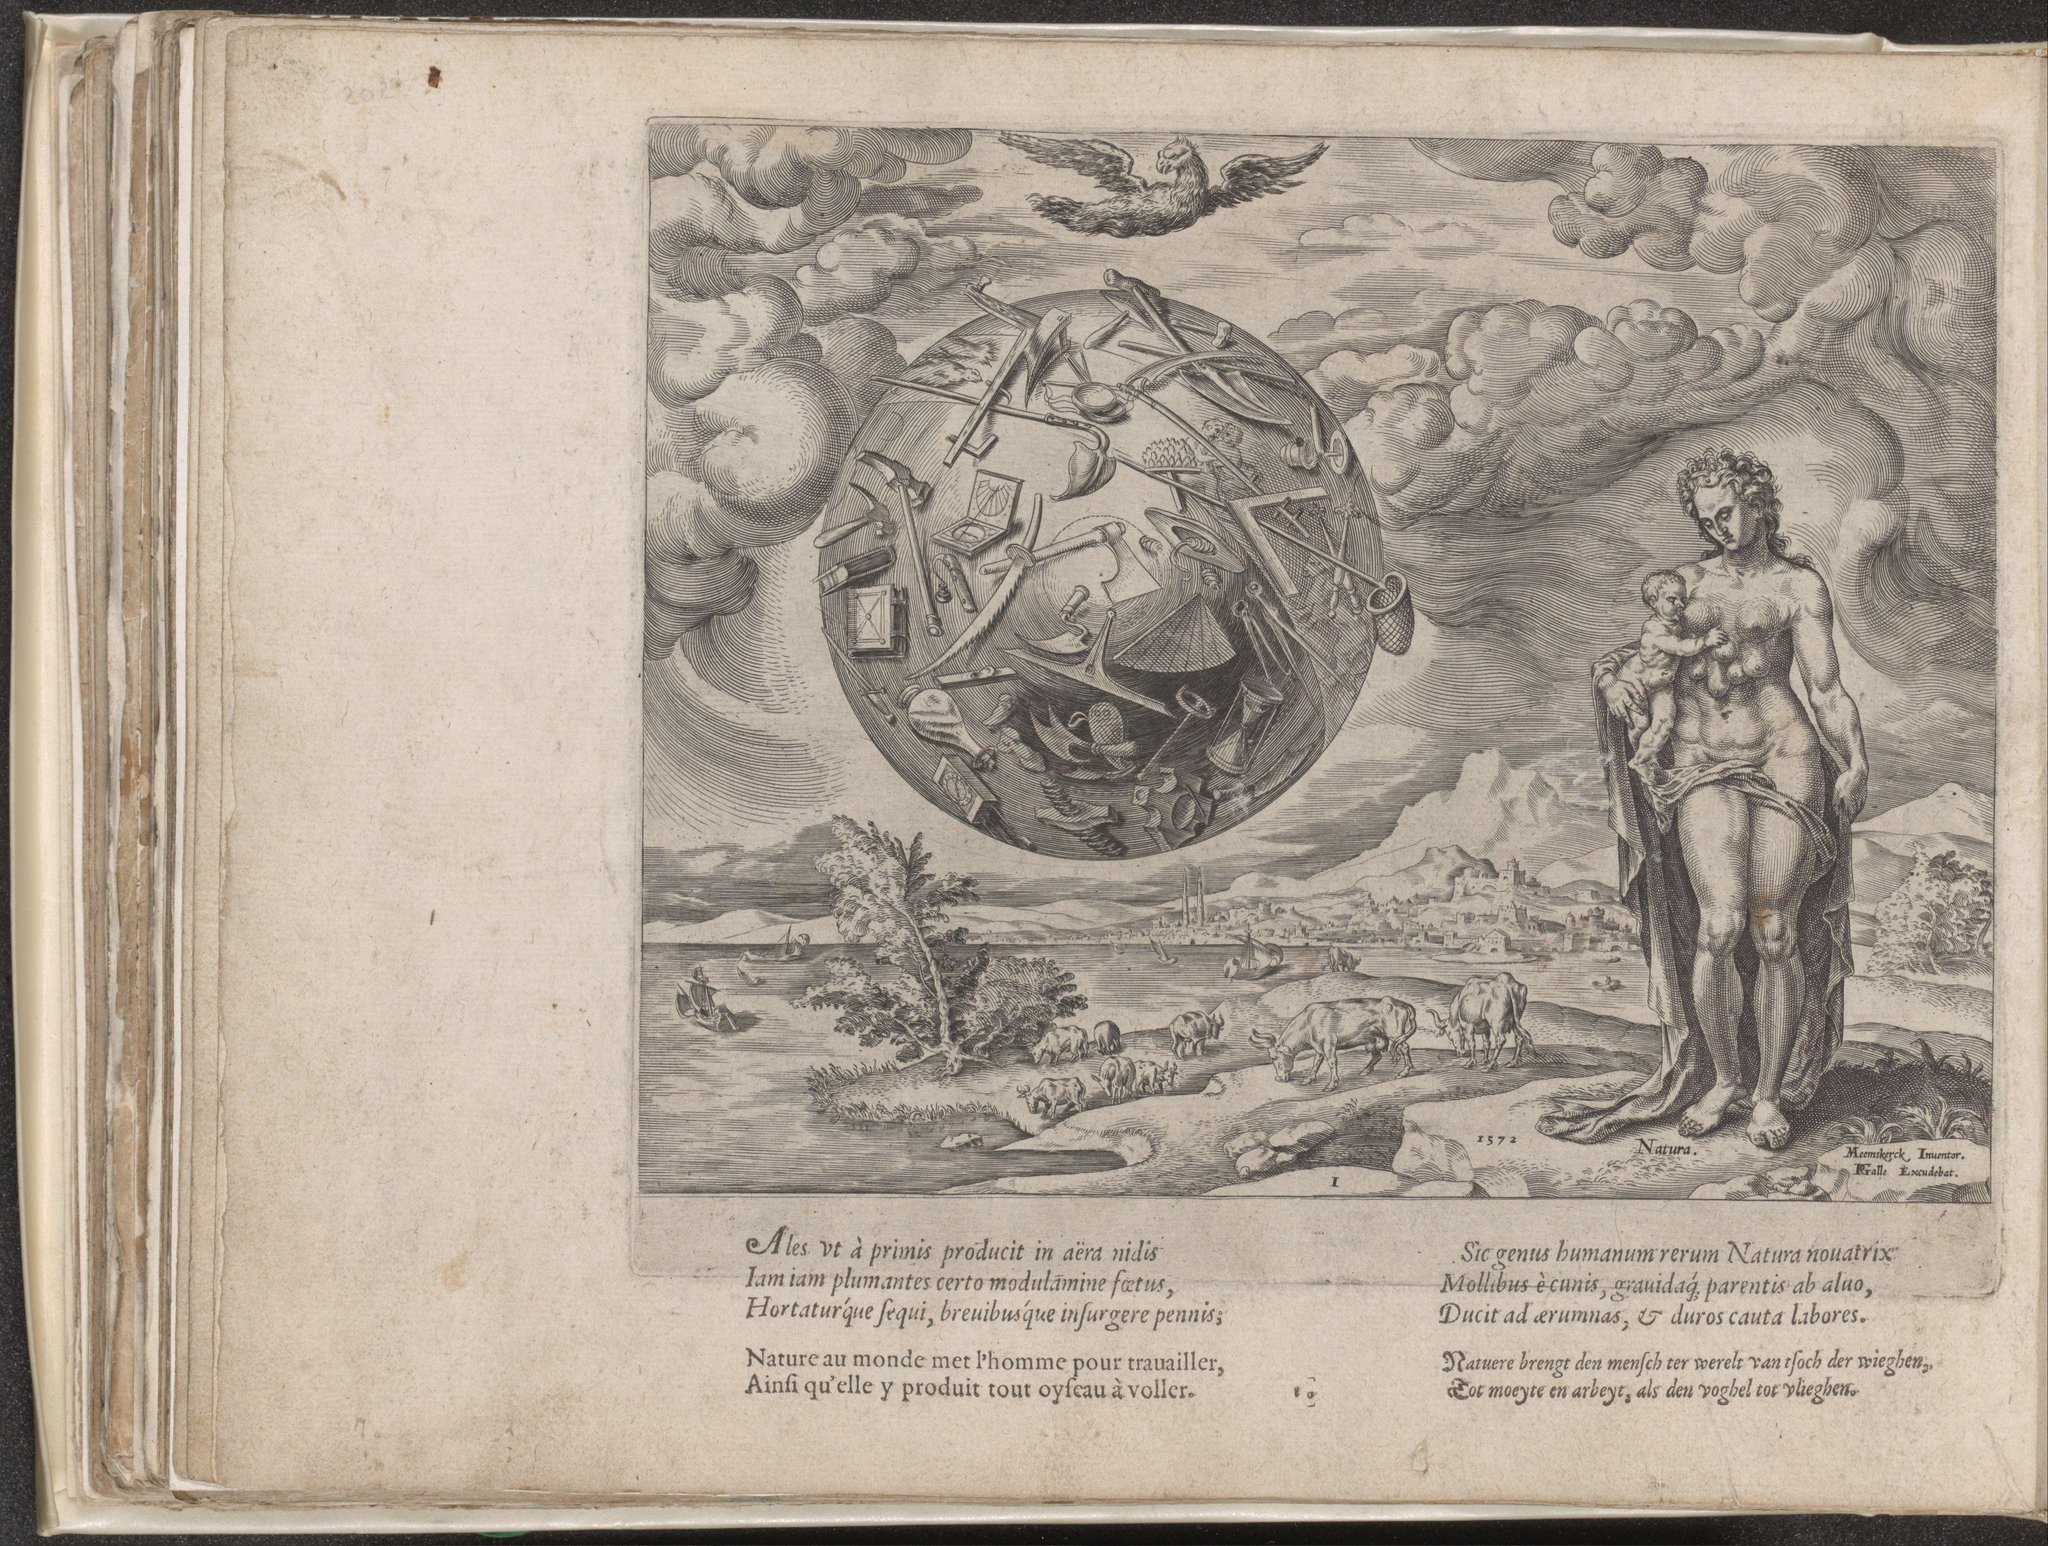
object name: print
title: Beloning voor arbeid en vlijt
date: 1572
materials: paper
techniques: engraving, letterpress printing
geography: antwerp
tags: 'natura' (allegorical figure or scene; or as diana of ephesus, with many breasts); 'natura' (ripa), tools, aids, implements ~ crafts and industries, predatory birds (+ flying animal(s)), nursing, suckling, globe, labour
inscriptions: date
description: Een jong kind zuigt aan de borst van de personificatie van de Natuur (Natura). In de lucht zweeft een wereldbol, met allerlei werktuigen die de mens gebruikt bij zijn dagelijkse arbeid. Boven de wereldbol vliegt een vogel: zoals een vogel geschapen is om te vliegen, zo ligt het in de natuur van de mens om in zijn leven te werken. Onder de voorstelling twee verzen in het Latijn en een Frans en Nederlands onderschrift in boekdruk. Deze prent maakt deel uit van een album.